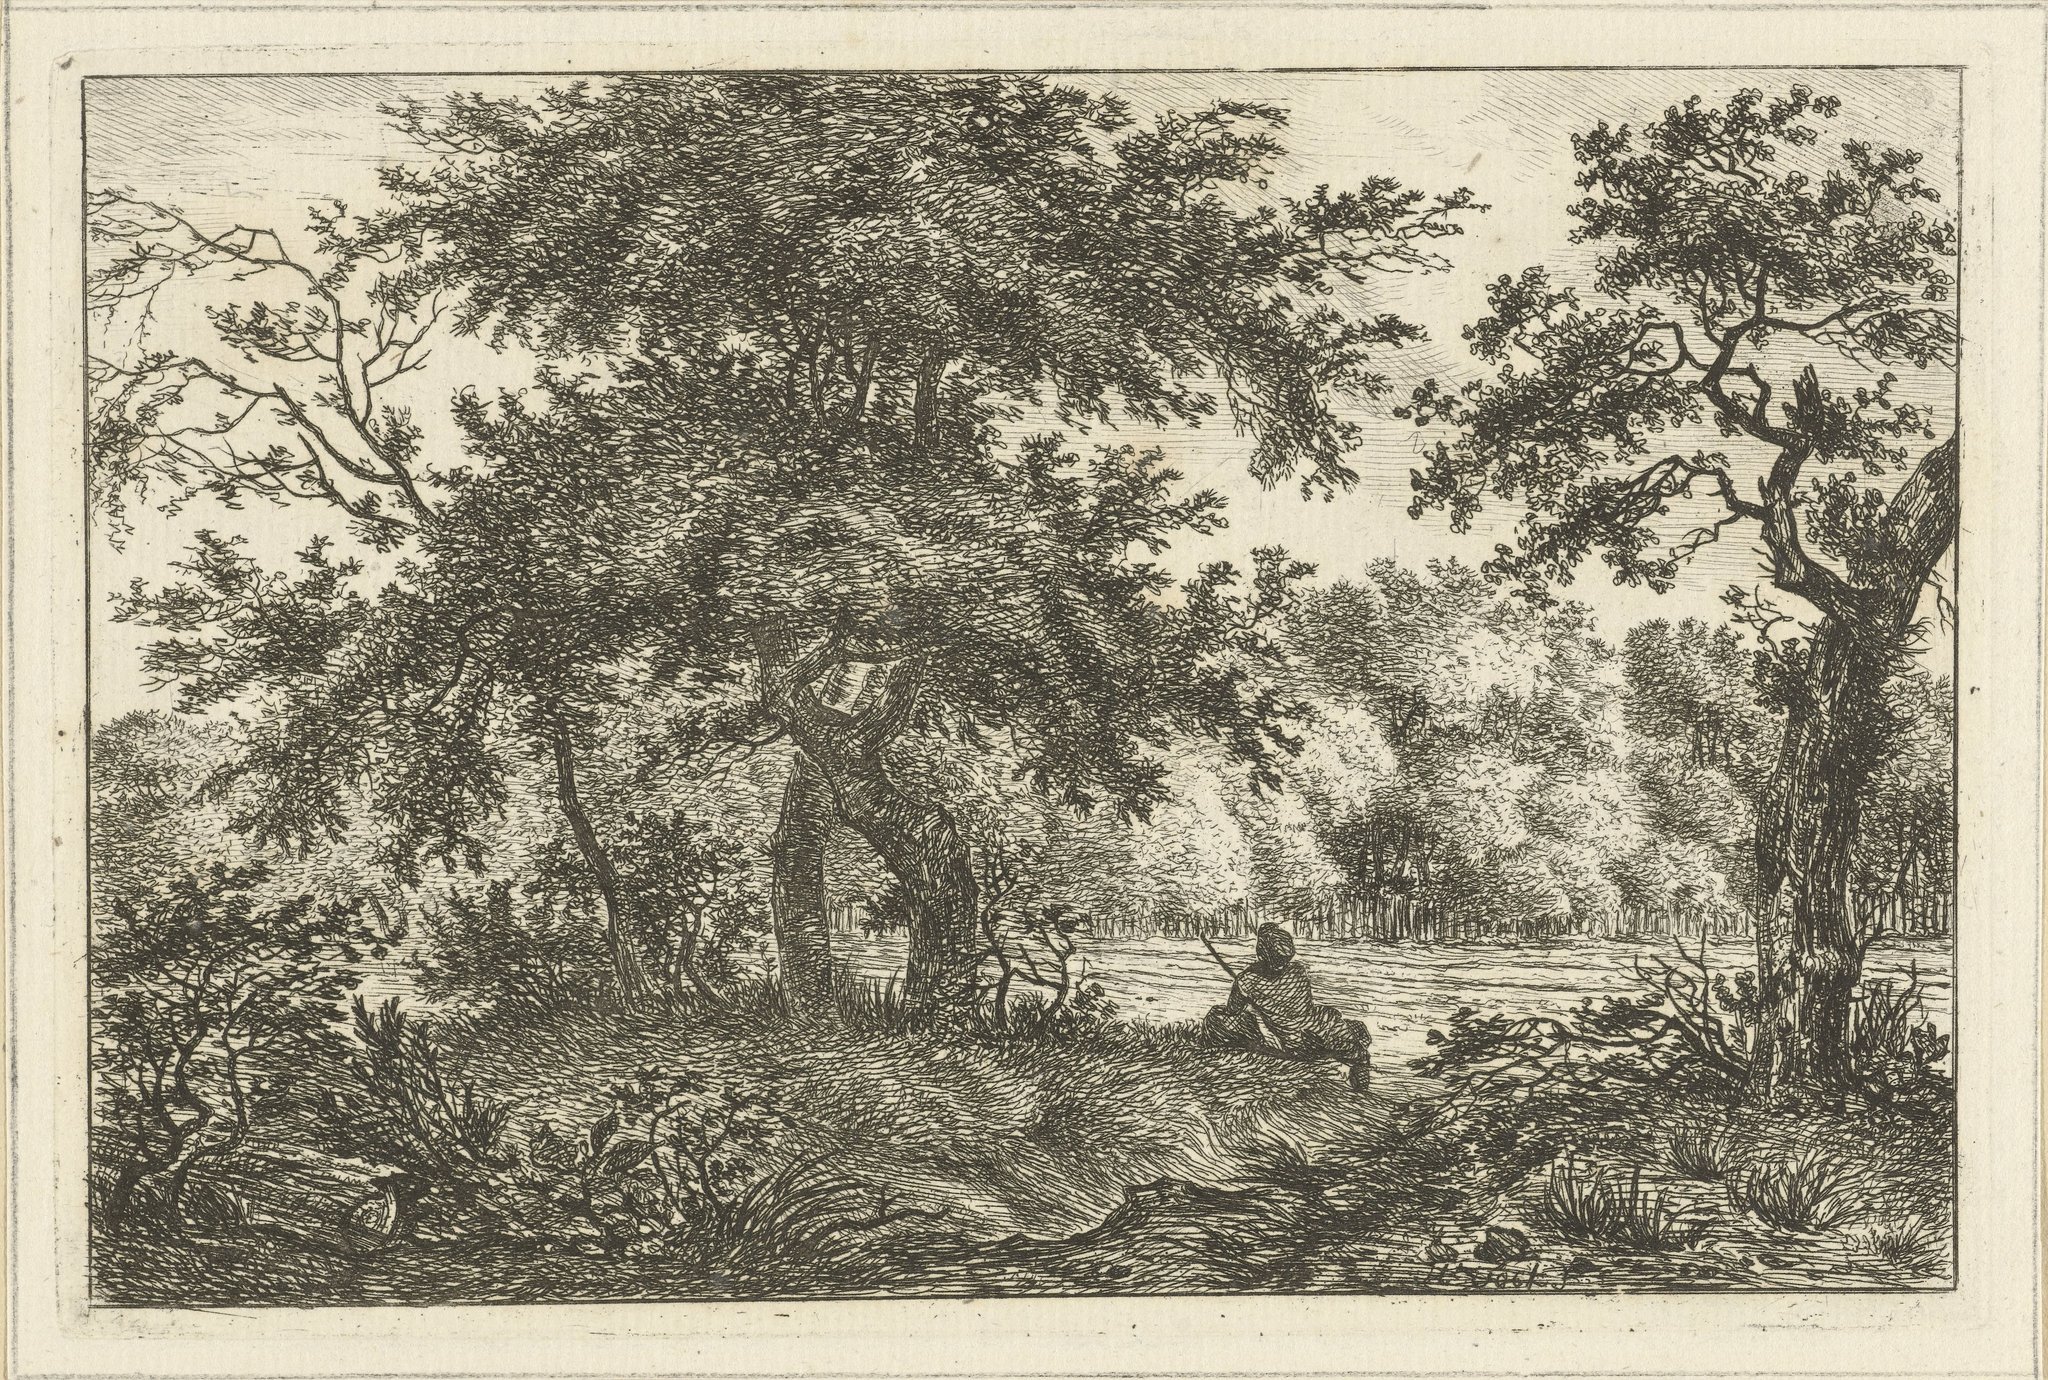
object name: print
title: Rustende man in bos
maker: hermanus fock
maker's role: conservator, draughtsman, painter, print maker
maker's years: 1766-1822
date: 1781-1822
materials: paper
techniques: etching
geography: amsterdam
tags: forest, wood (+ landscape with figures, staffage), resting - bb - out of doors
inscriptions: collector's mark: Lugt 924, collector's mark: Lugt 2228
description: Een man zit in het gras onder een boom op de grens van een bos en een weide.